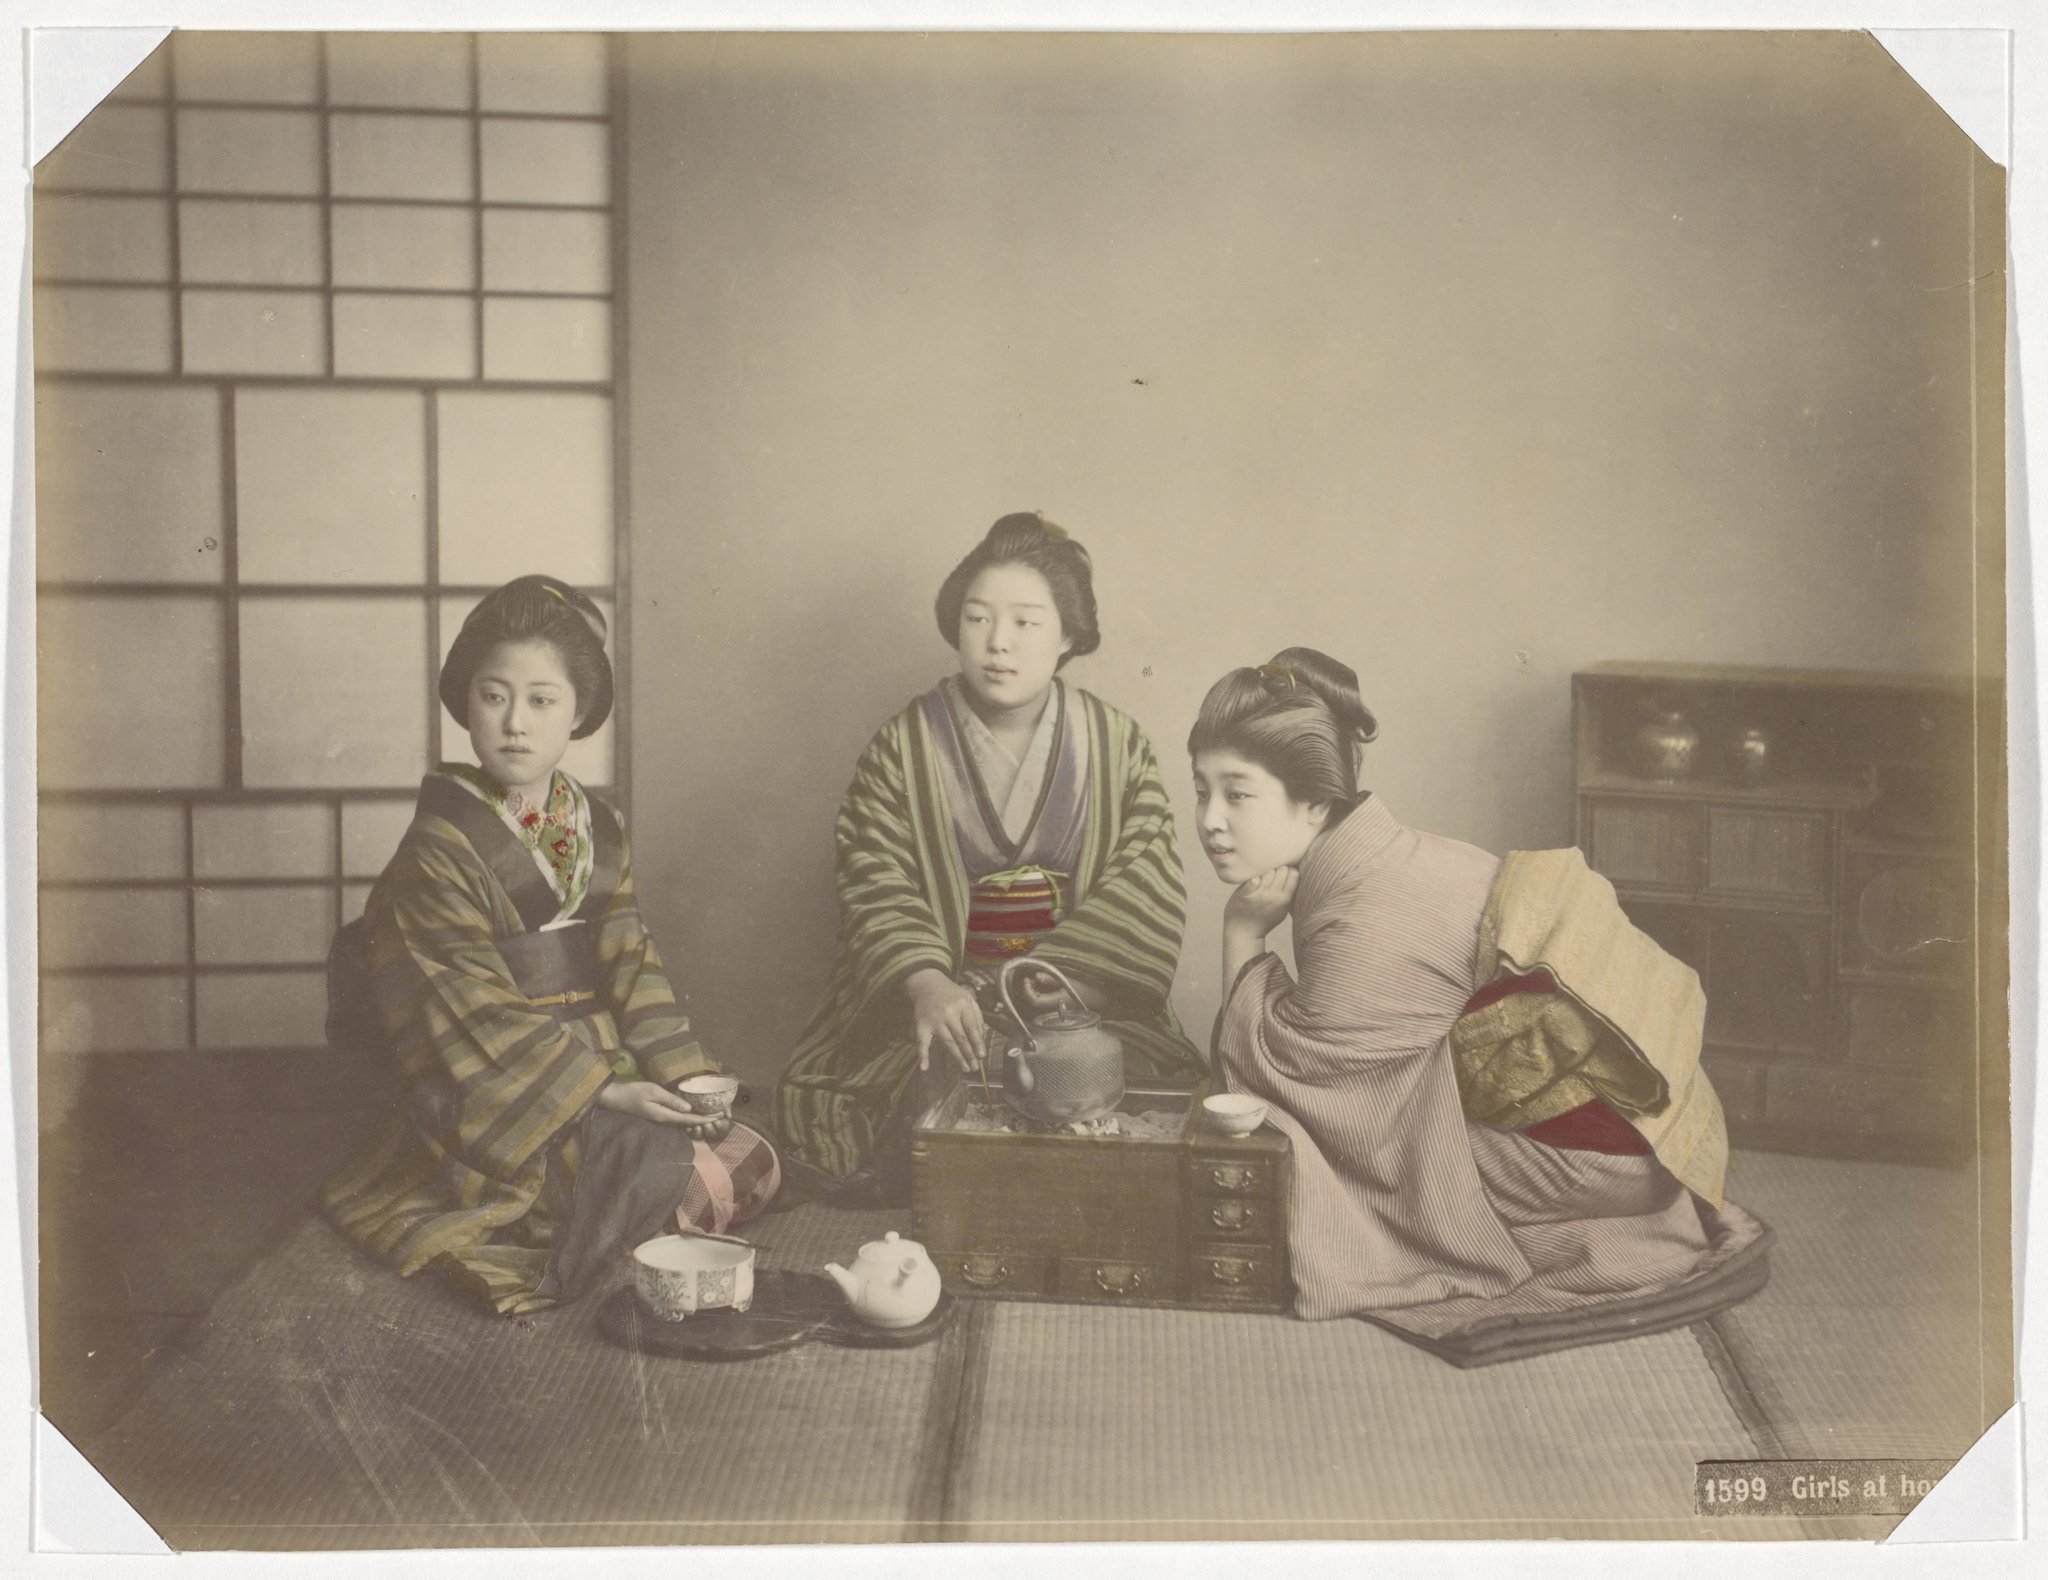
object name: photograph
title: Girls at home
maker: Anonymous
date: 1890-1894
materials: cardboard, paper, photographic support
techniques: albumen print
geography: japan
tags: tea-ceremony, japan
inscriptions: negative number: ‘1599’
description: Onderdeel van Album met 69 foto's van een reis door Japan.